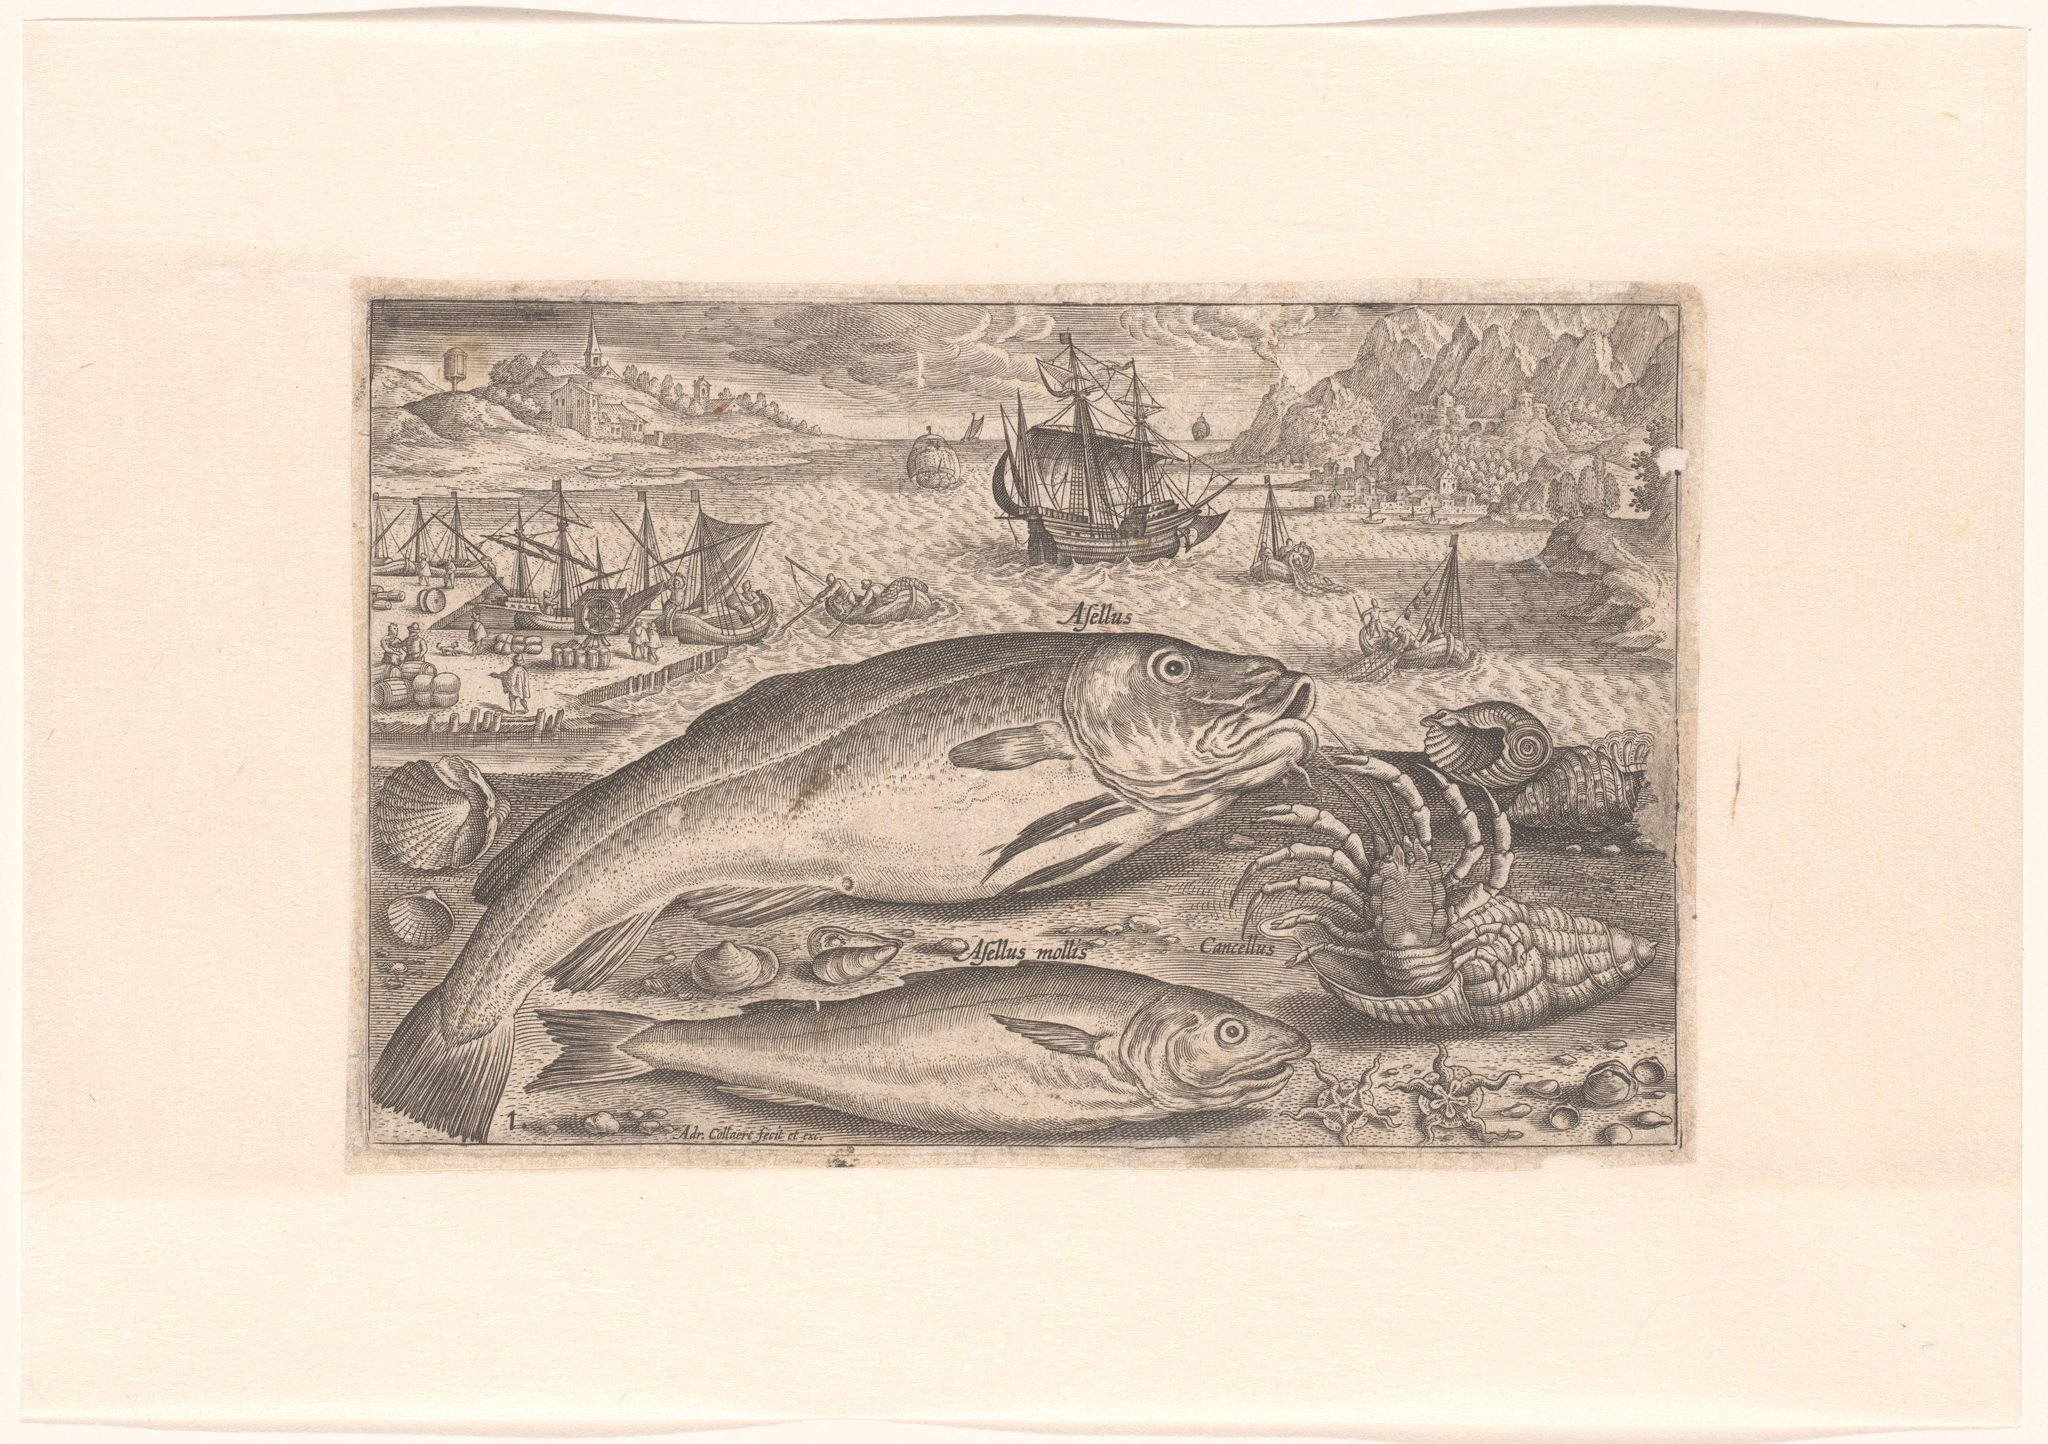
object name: print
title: Vissen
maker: adriaen collaert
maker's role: draughtsman, print maker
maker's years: 1560-1618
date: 1598-1618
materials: paper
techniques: engraving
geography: antwerp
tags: pier, quay, wharf, crustaceans: crab, bony fishes: whiting, bony fishes: cod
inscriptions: collector's mark: Lugt 2228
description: Een kabeljauw, een wijting en een hermietkreeft liggen samen met wat schelpen aangespoeld op het strand. Op de achtergrond de zee en een havenkade. De prent maakt deel uit van een serie met vissen als onderwerp.